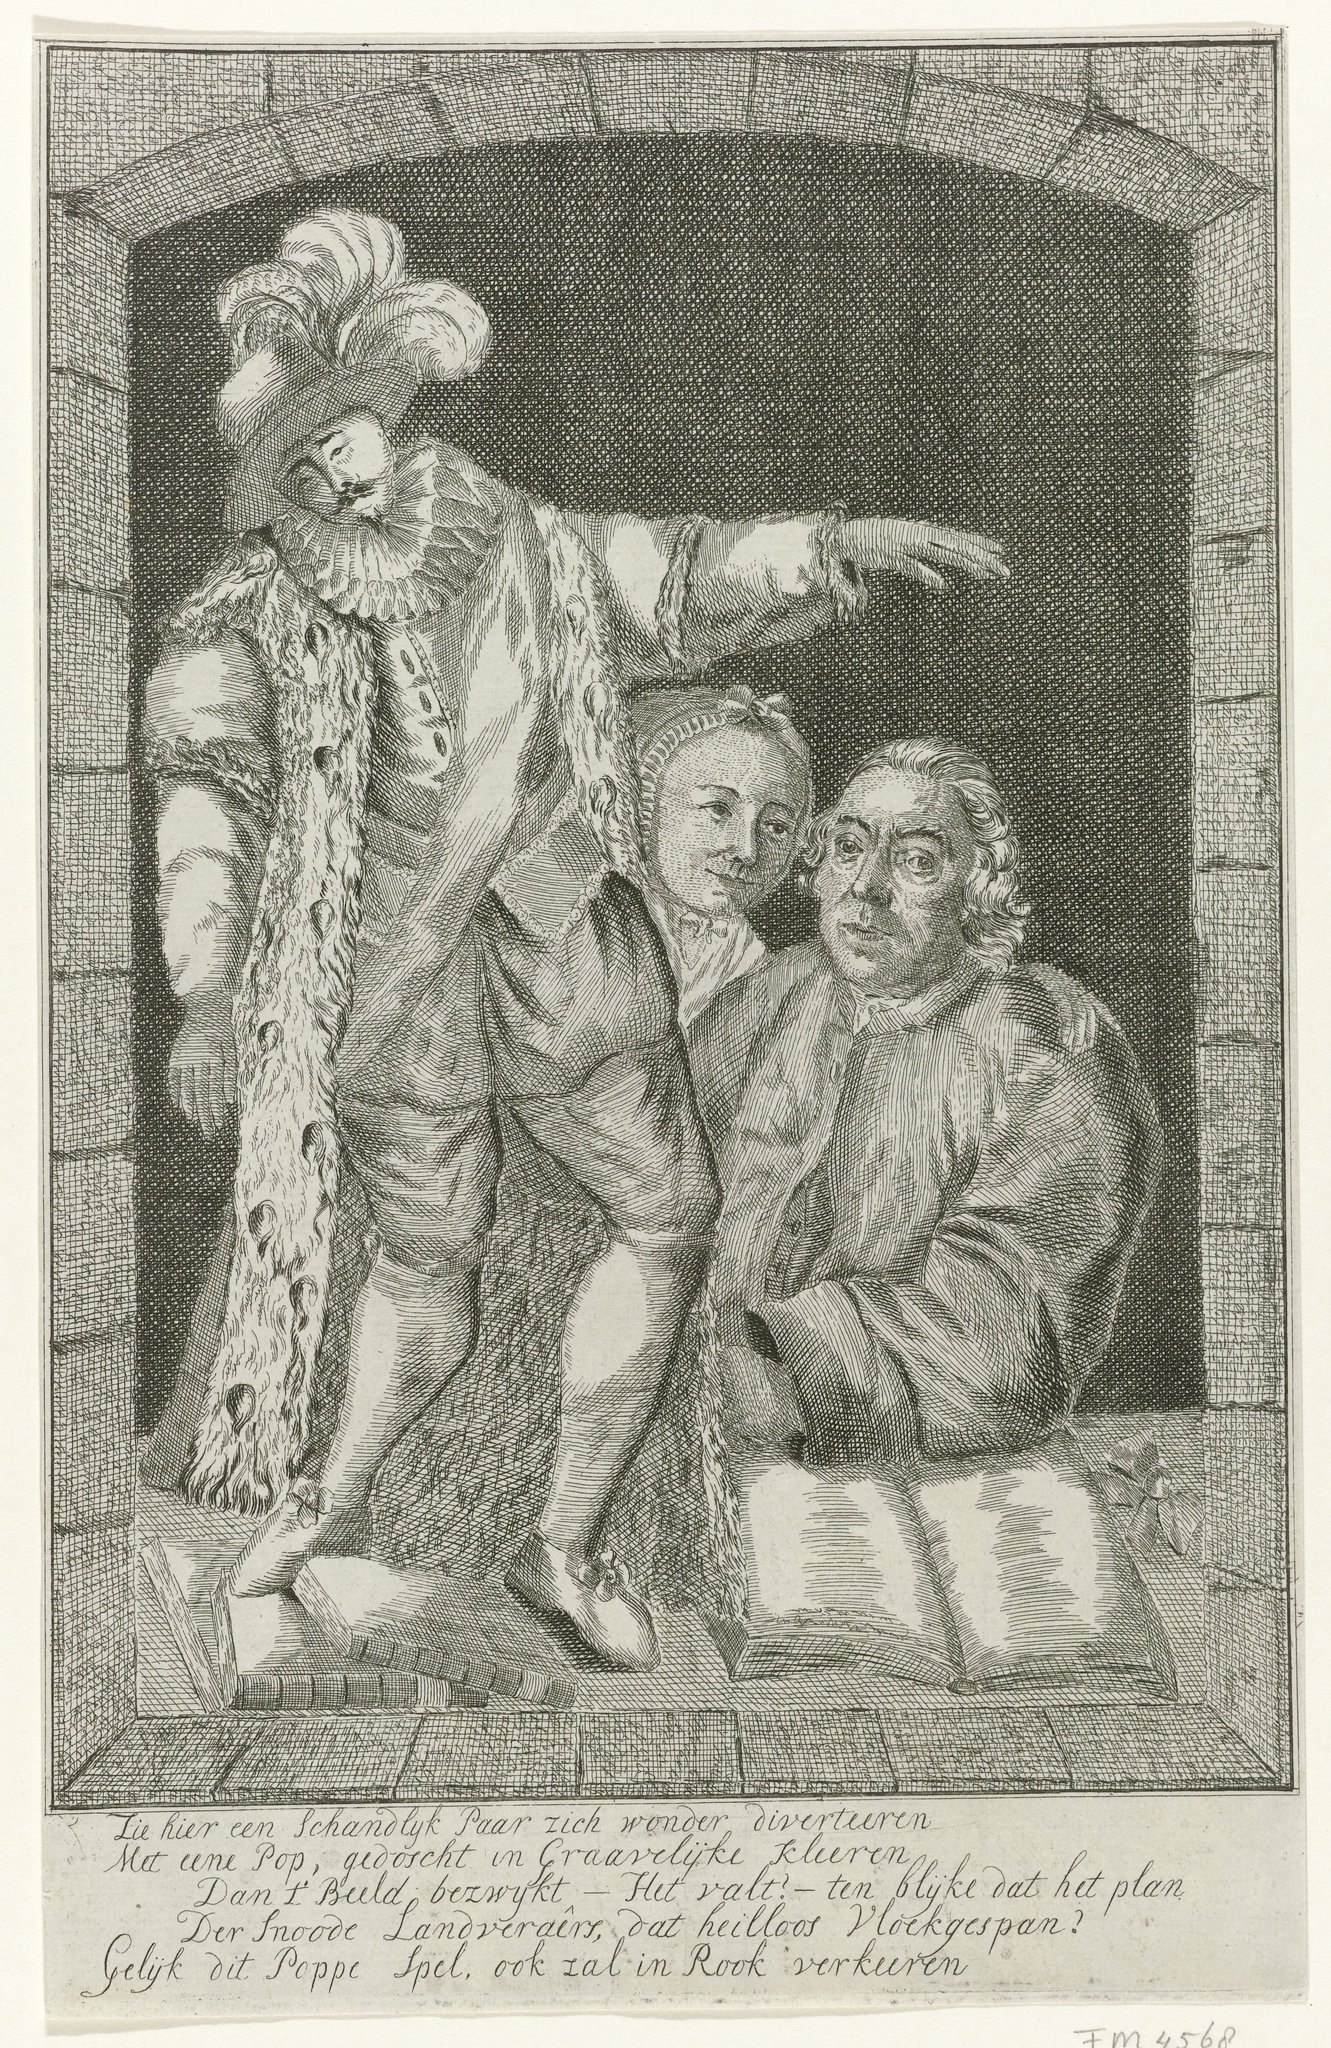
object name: print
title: Spotprent op Johannes le Francq van Berkhey als de Poppeman, 1784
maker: Anonymous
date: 1784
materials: paper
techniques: engraving, etching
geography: northern netherlands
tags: leiden, print maker, johannes le francq van berkhey, dolls for adults, patriots (1780-1795)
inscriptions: collector's mark: Lugt 2228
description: Spotprent op de prinsgezinde Johannes le Francq van Berkhey als de Poppeman die op de verjaardag van de prins op 8 maart 1784 zijn huis te Leiden geïllumineerd en versierd had met poppen. Johannes le Francq van Berkhey met zijn huishoudster Hester van Dienderen met een pop en enkele boeken in de stenen venster van het huis. In het onderschrift een vijfregelig vers.